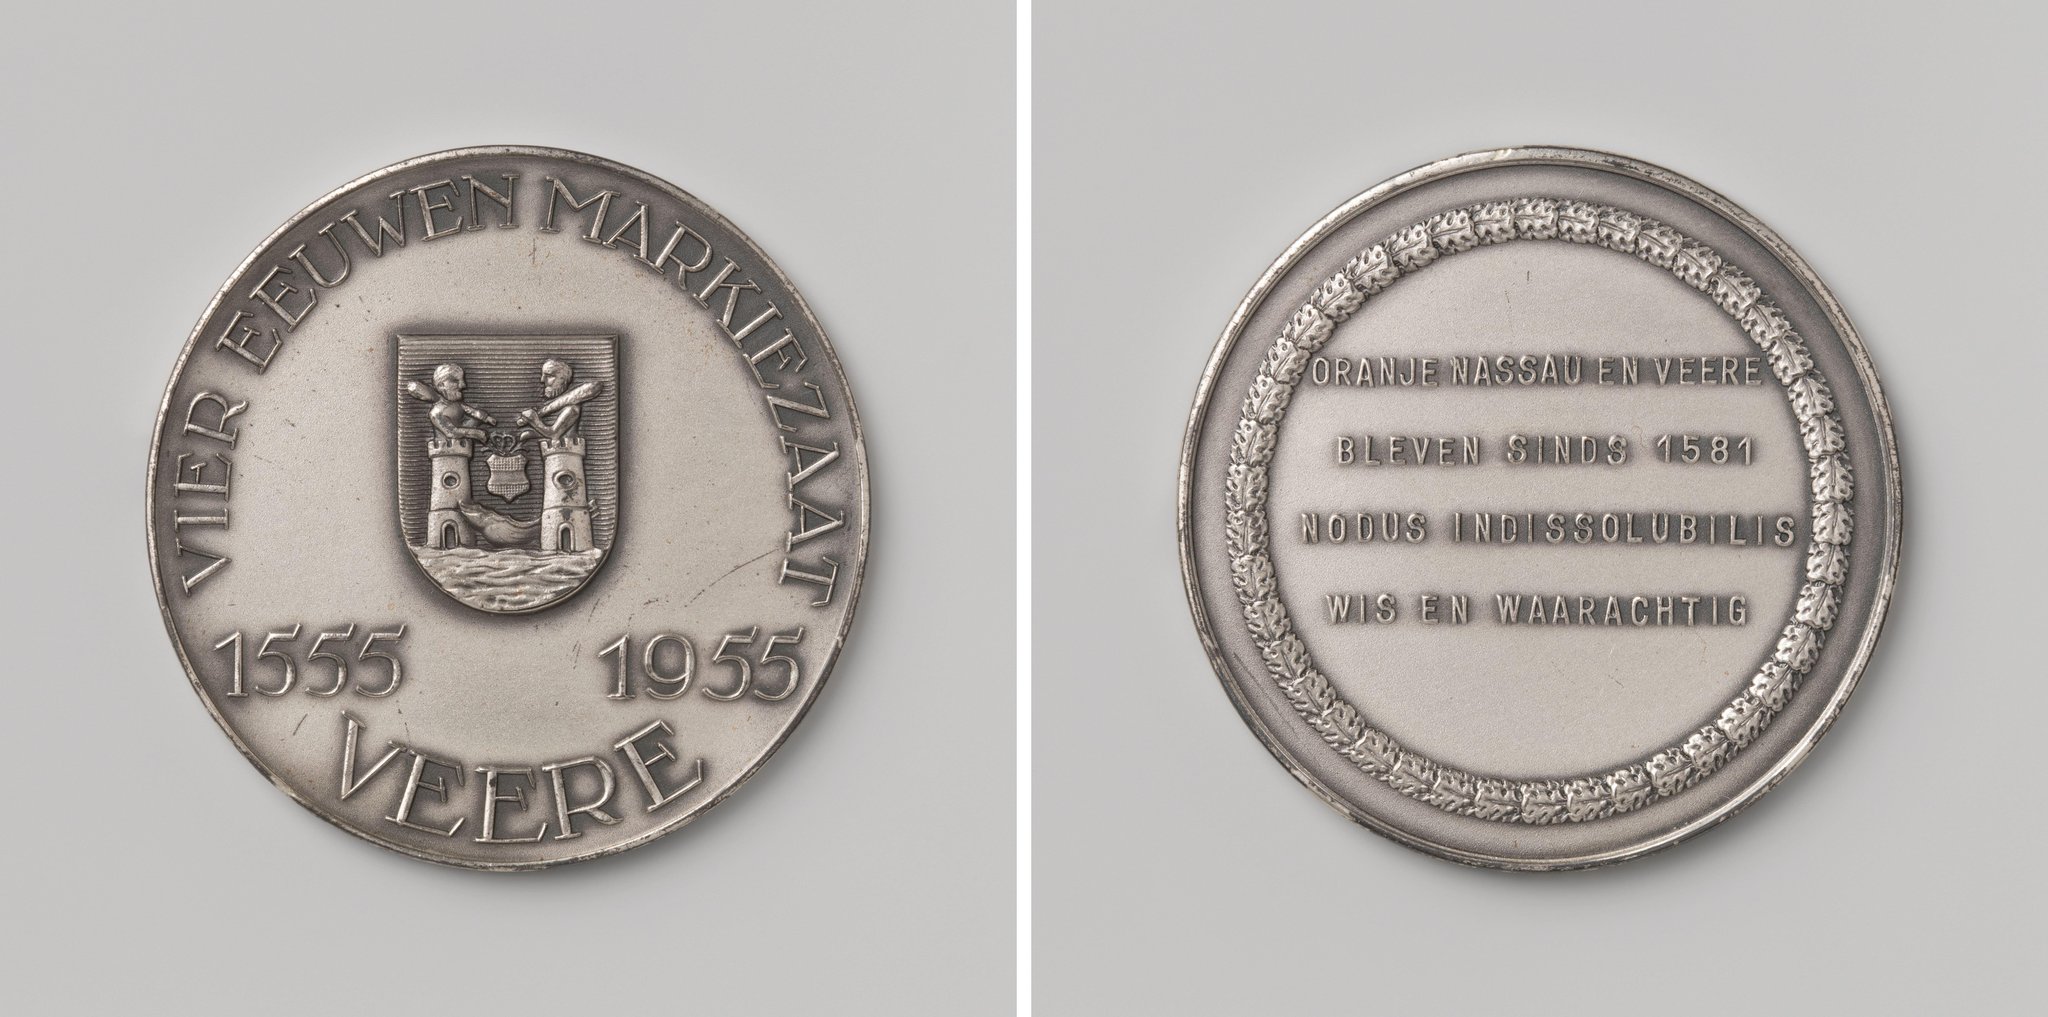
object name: history medal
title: vierhonderdjarig bestaan van het markiezaat Veere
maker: Anonymous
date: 1955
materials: silver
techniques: striking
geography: netherlands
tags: veere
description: Zilveren penning. Voorzijde: wapenschild boven twee jaartallen binnen omschrift. Keerzijde: opschrift binnen eikekrans